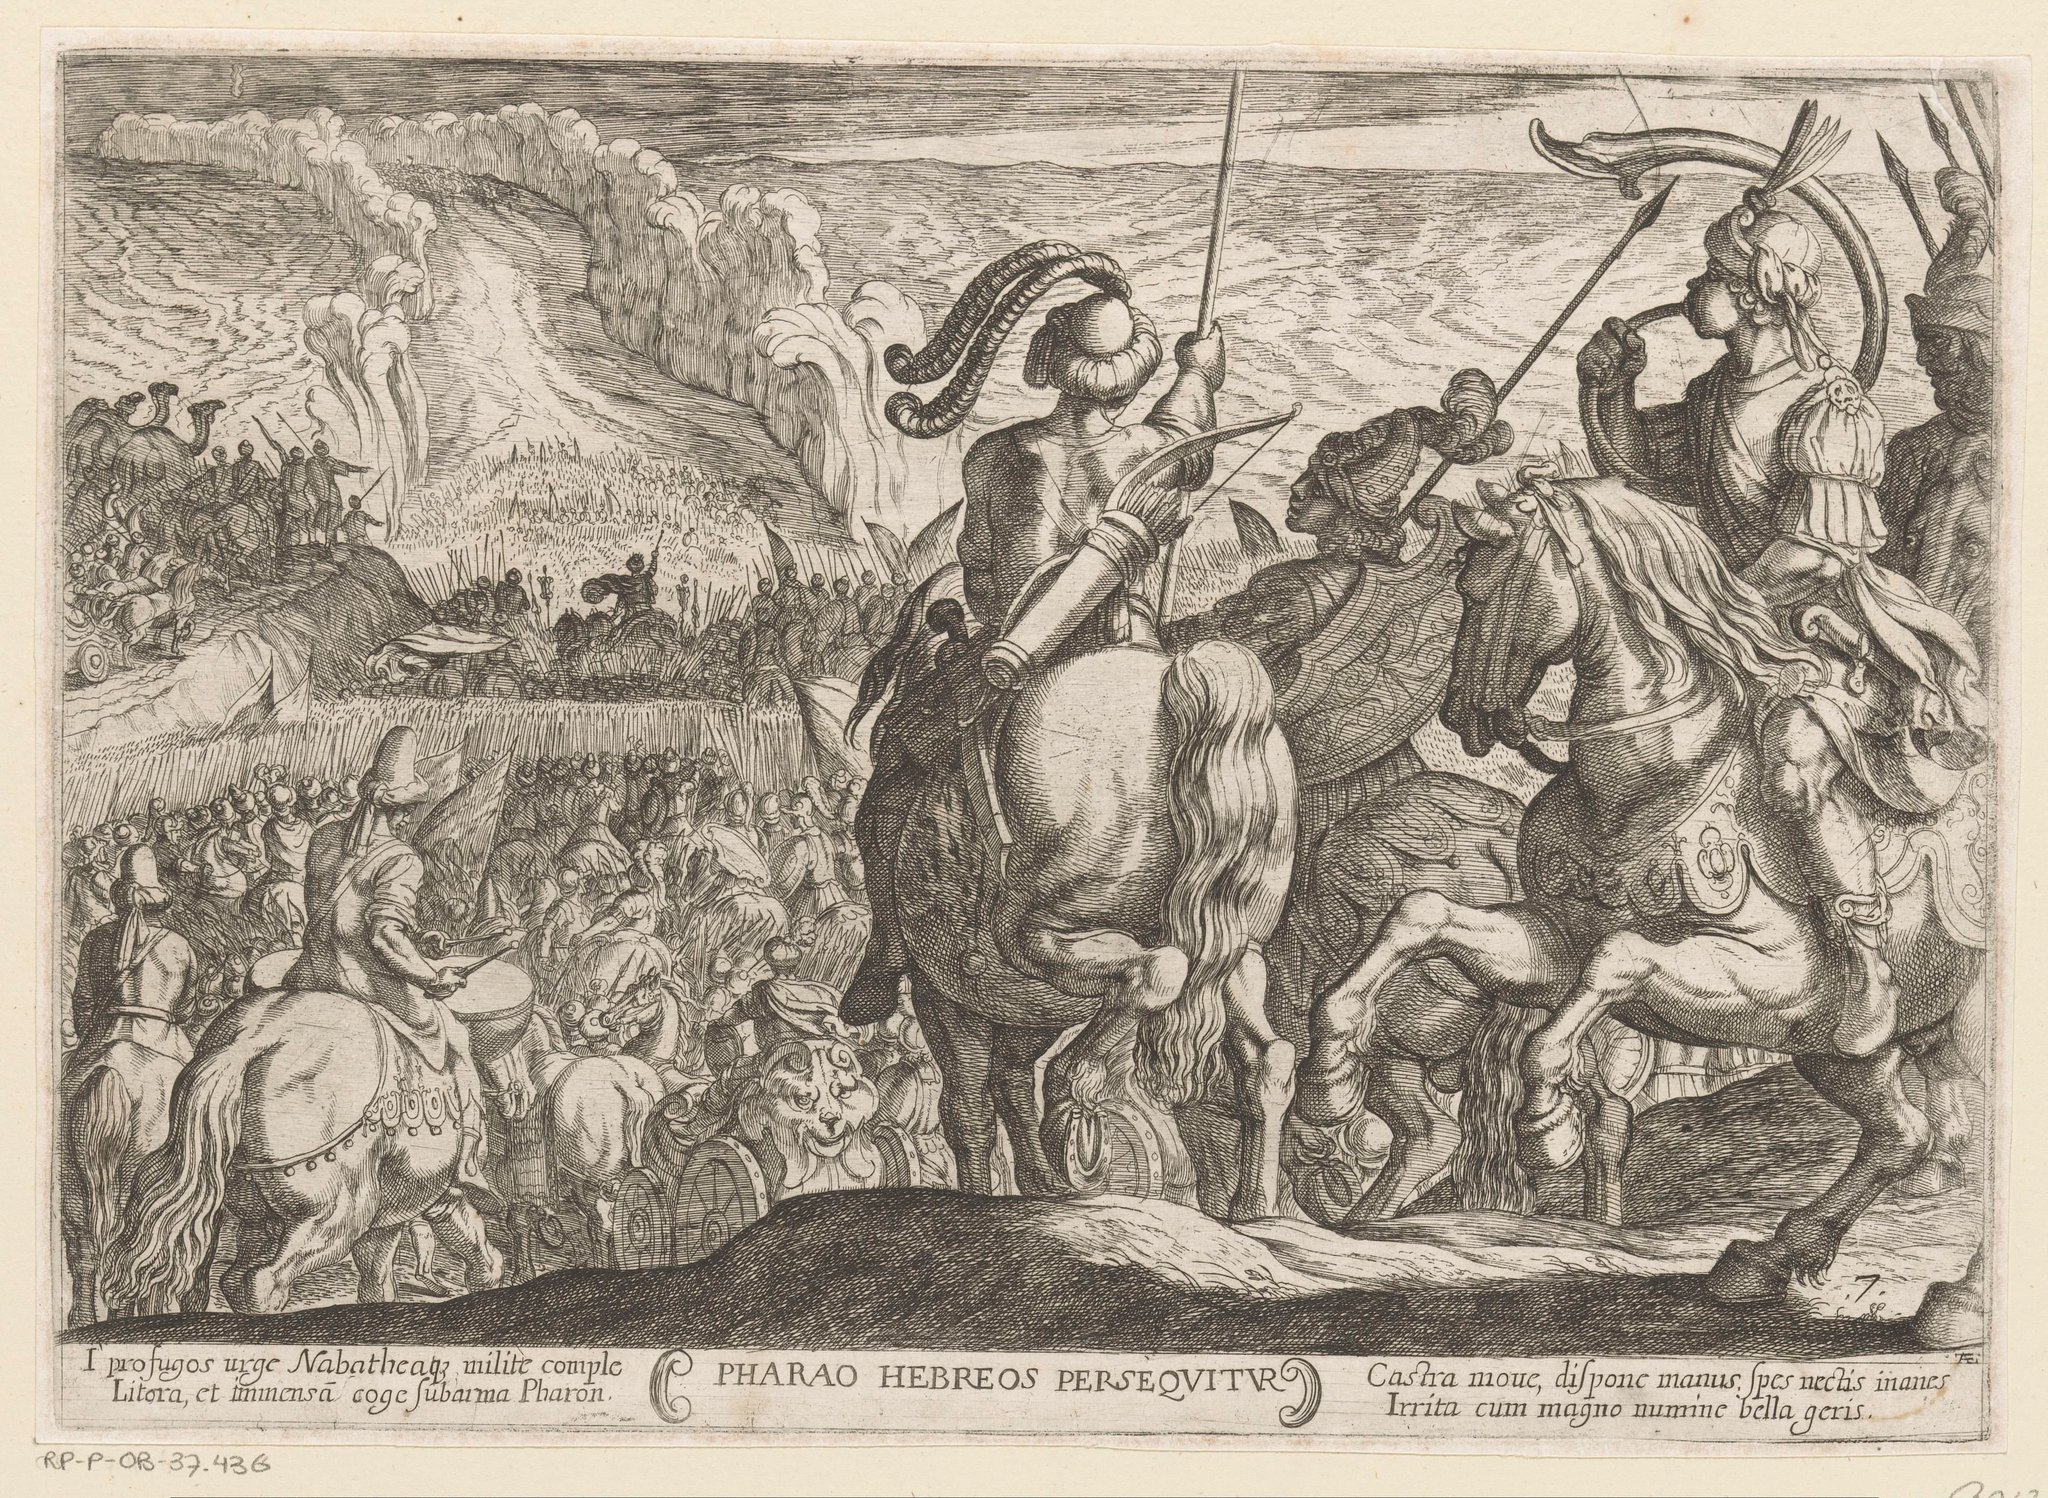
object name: print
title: Oudtestamentische strijdscènes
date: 1613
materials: paper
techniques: etching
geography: italy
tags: pharaoh and his army set off in pursuit of the israelites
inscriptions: collector's mark: Lugt 240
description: Het leger van de farao achtervolgt Mozes en de Israëlieten door de Schelfzee. Titel en onderschrift in het Latijn in de ondermarge.